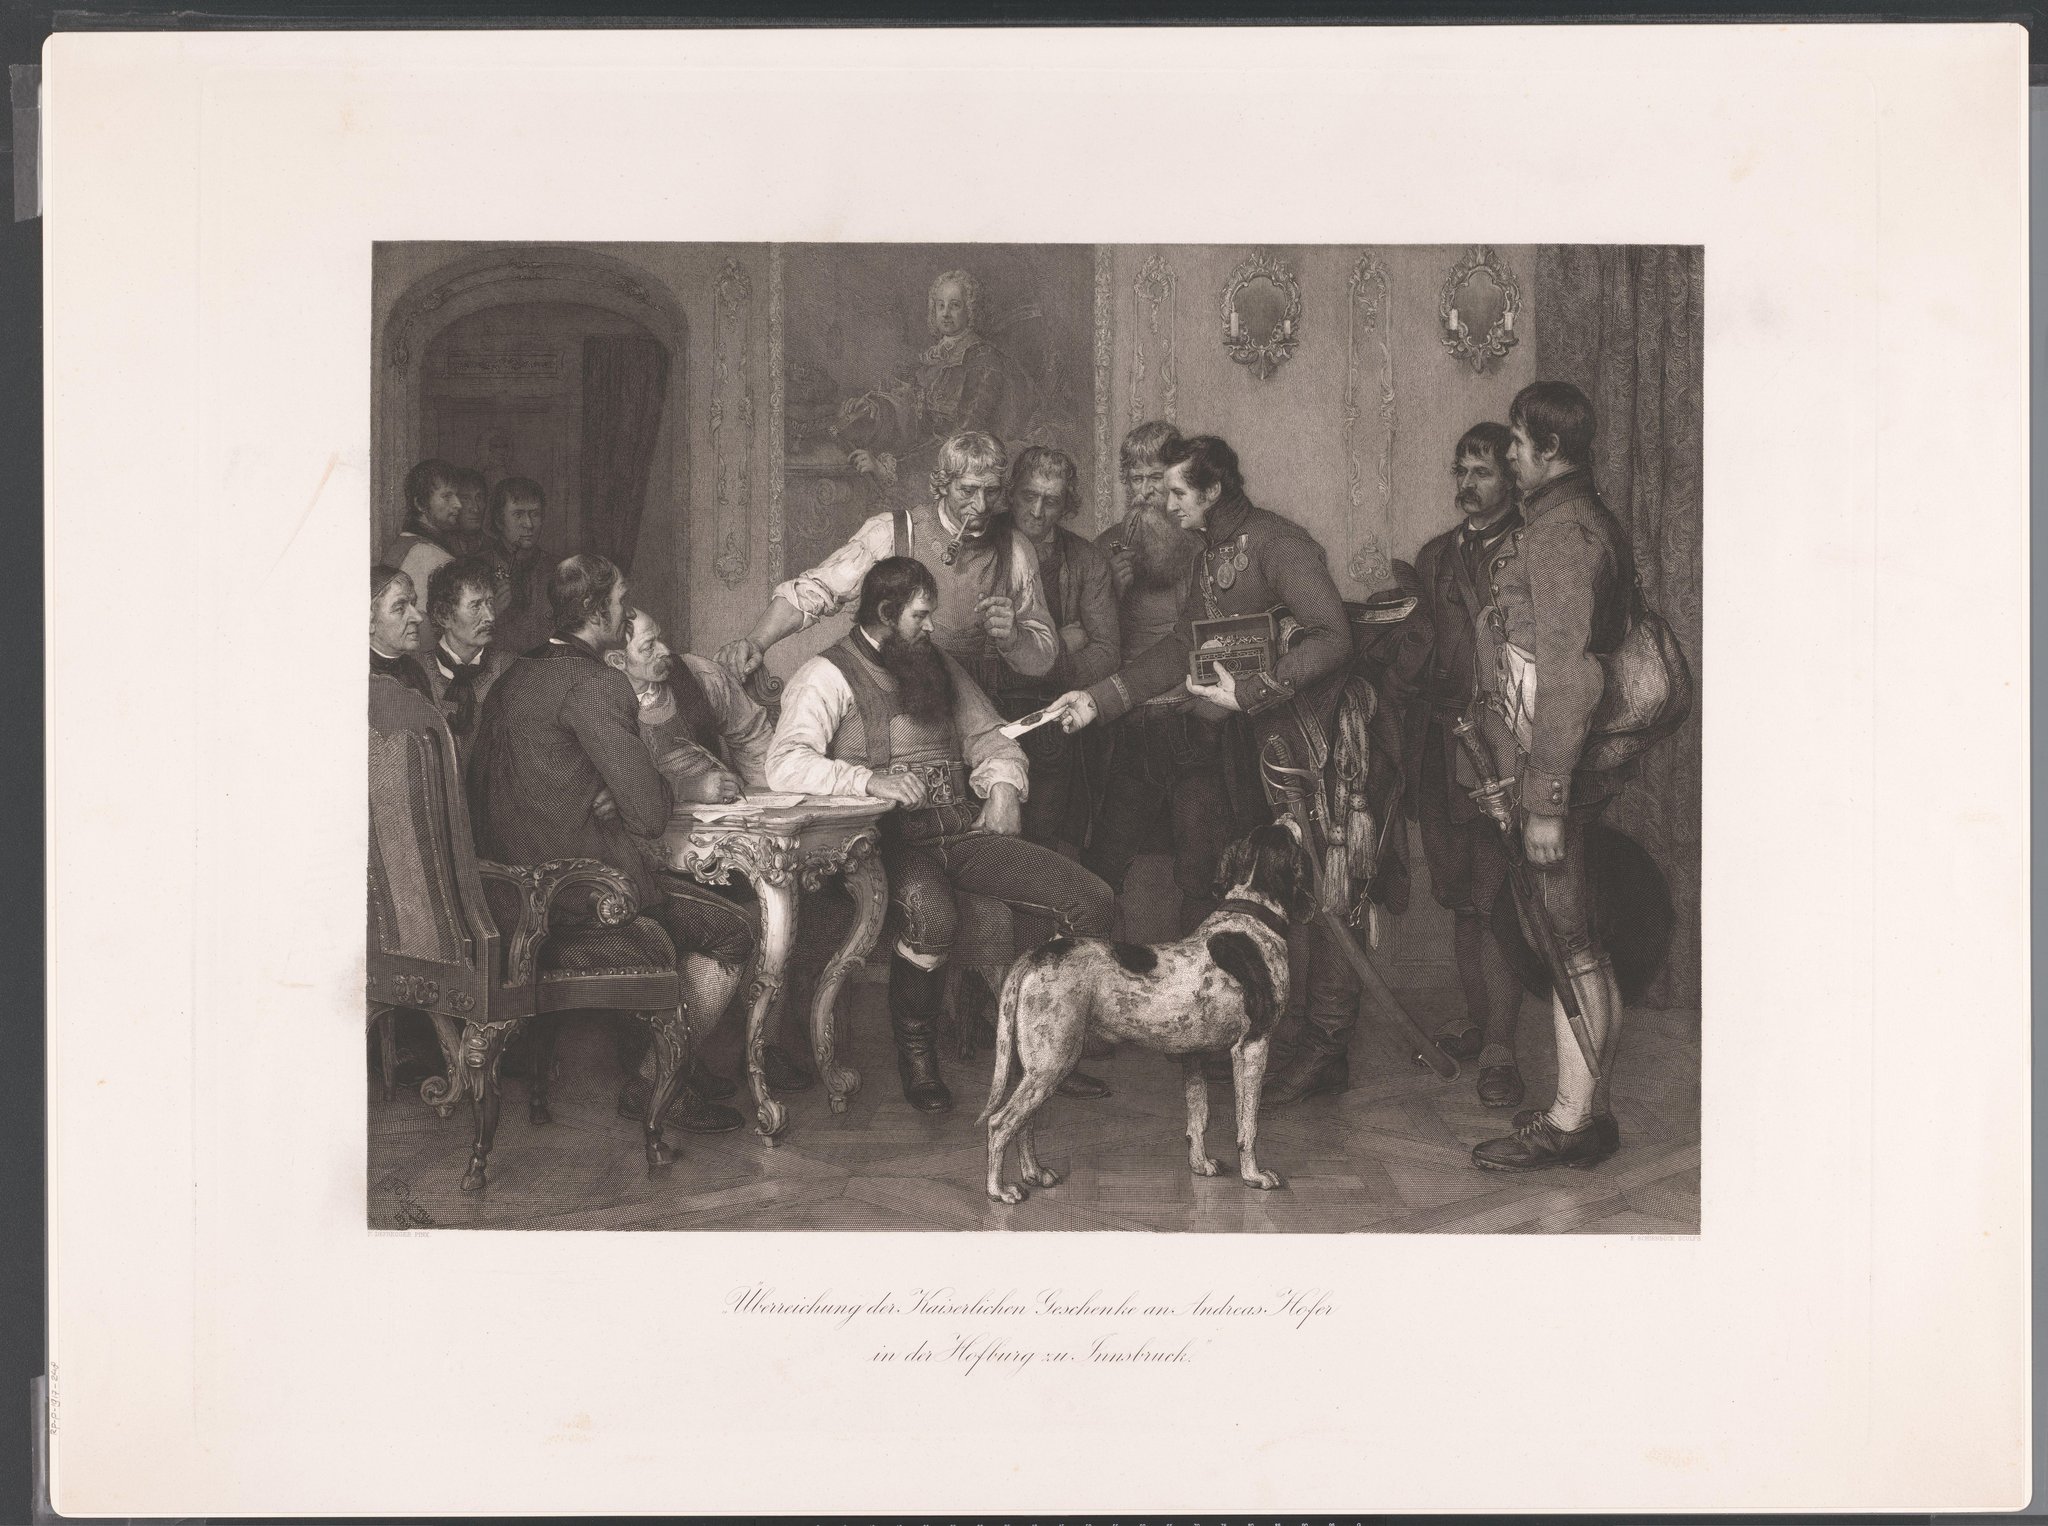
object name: print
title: Andreas Hofer ontvangt de keizerlijke geschenken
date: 1879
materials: paper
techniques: etching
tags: gifts being accepted, emperor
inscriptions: collector's mark: Lugt 2228